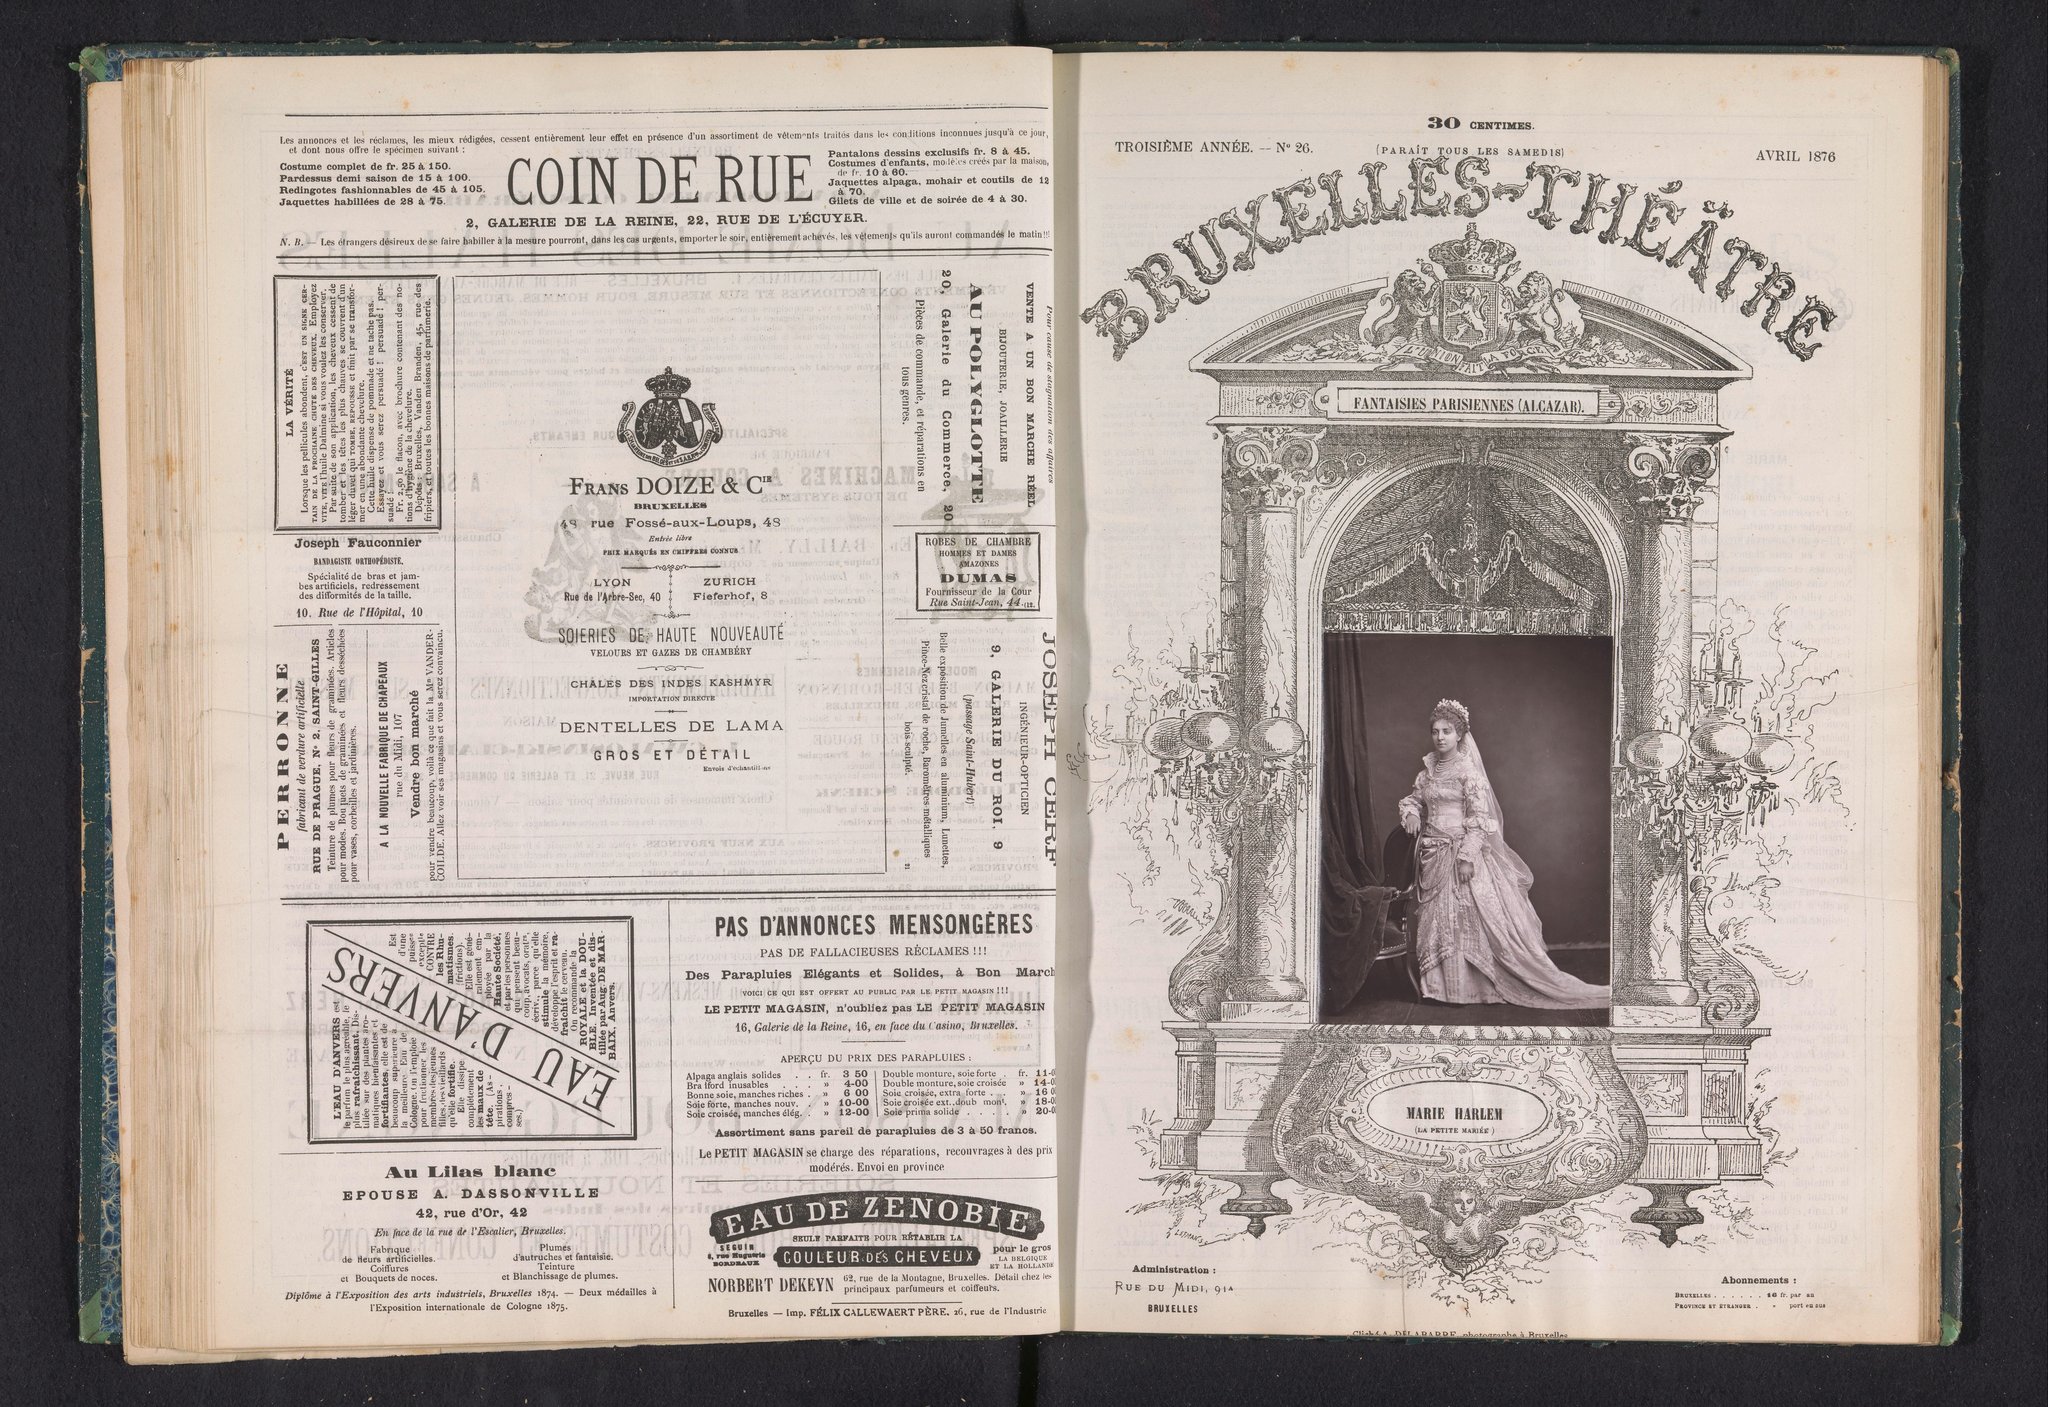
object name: page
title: Marie Harlem (La petite mariée)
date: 1871-1876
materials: paper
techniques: woodburytype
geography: brussels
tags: portrait of actor, actress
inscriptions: number: ‘No 26.’